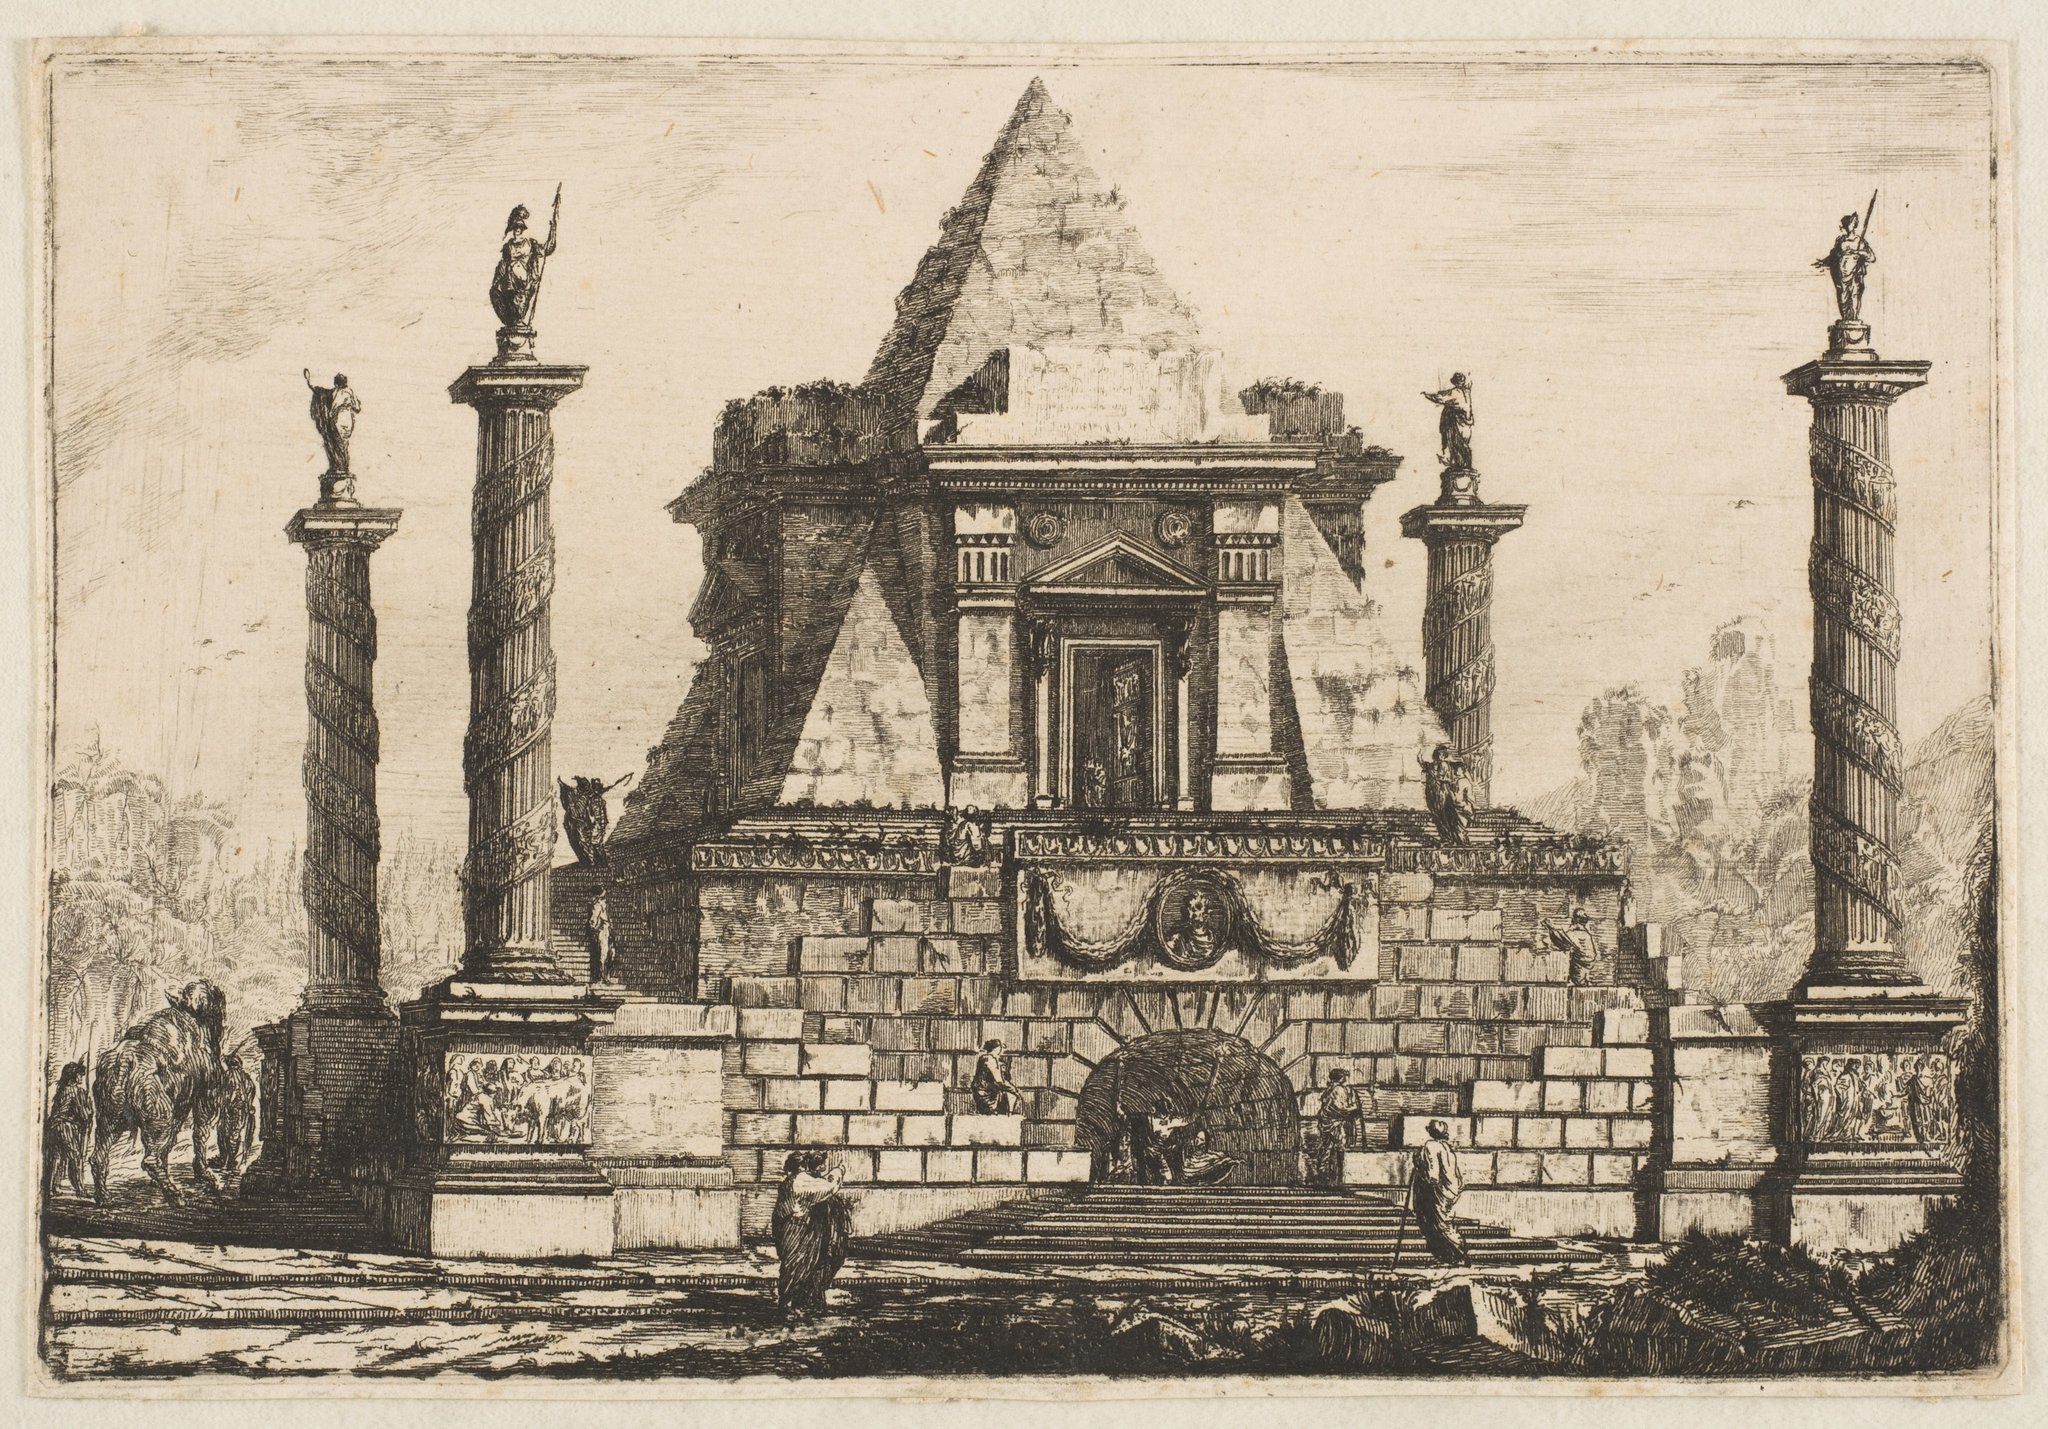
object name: print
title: View of a Funerary Monument and Crypt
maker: pierre moreau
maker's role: artist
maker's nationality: french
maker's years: 1715-1798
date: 1760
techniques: etching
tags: crypts,funerary monuments